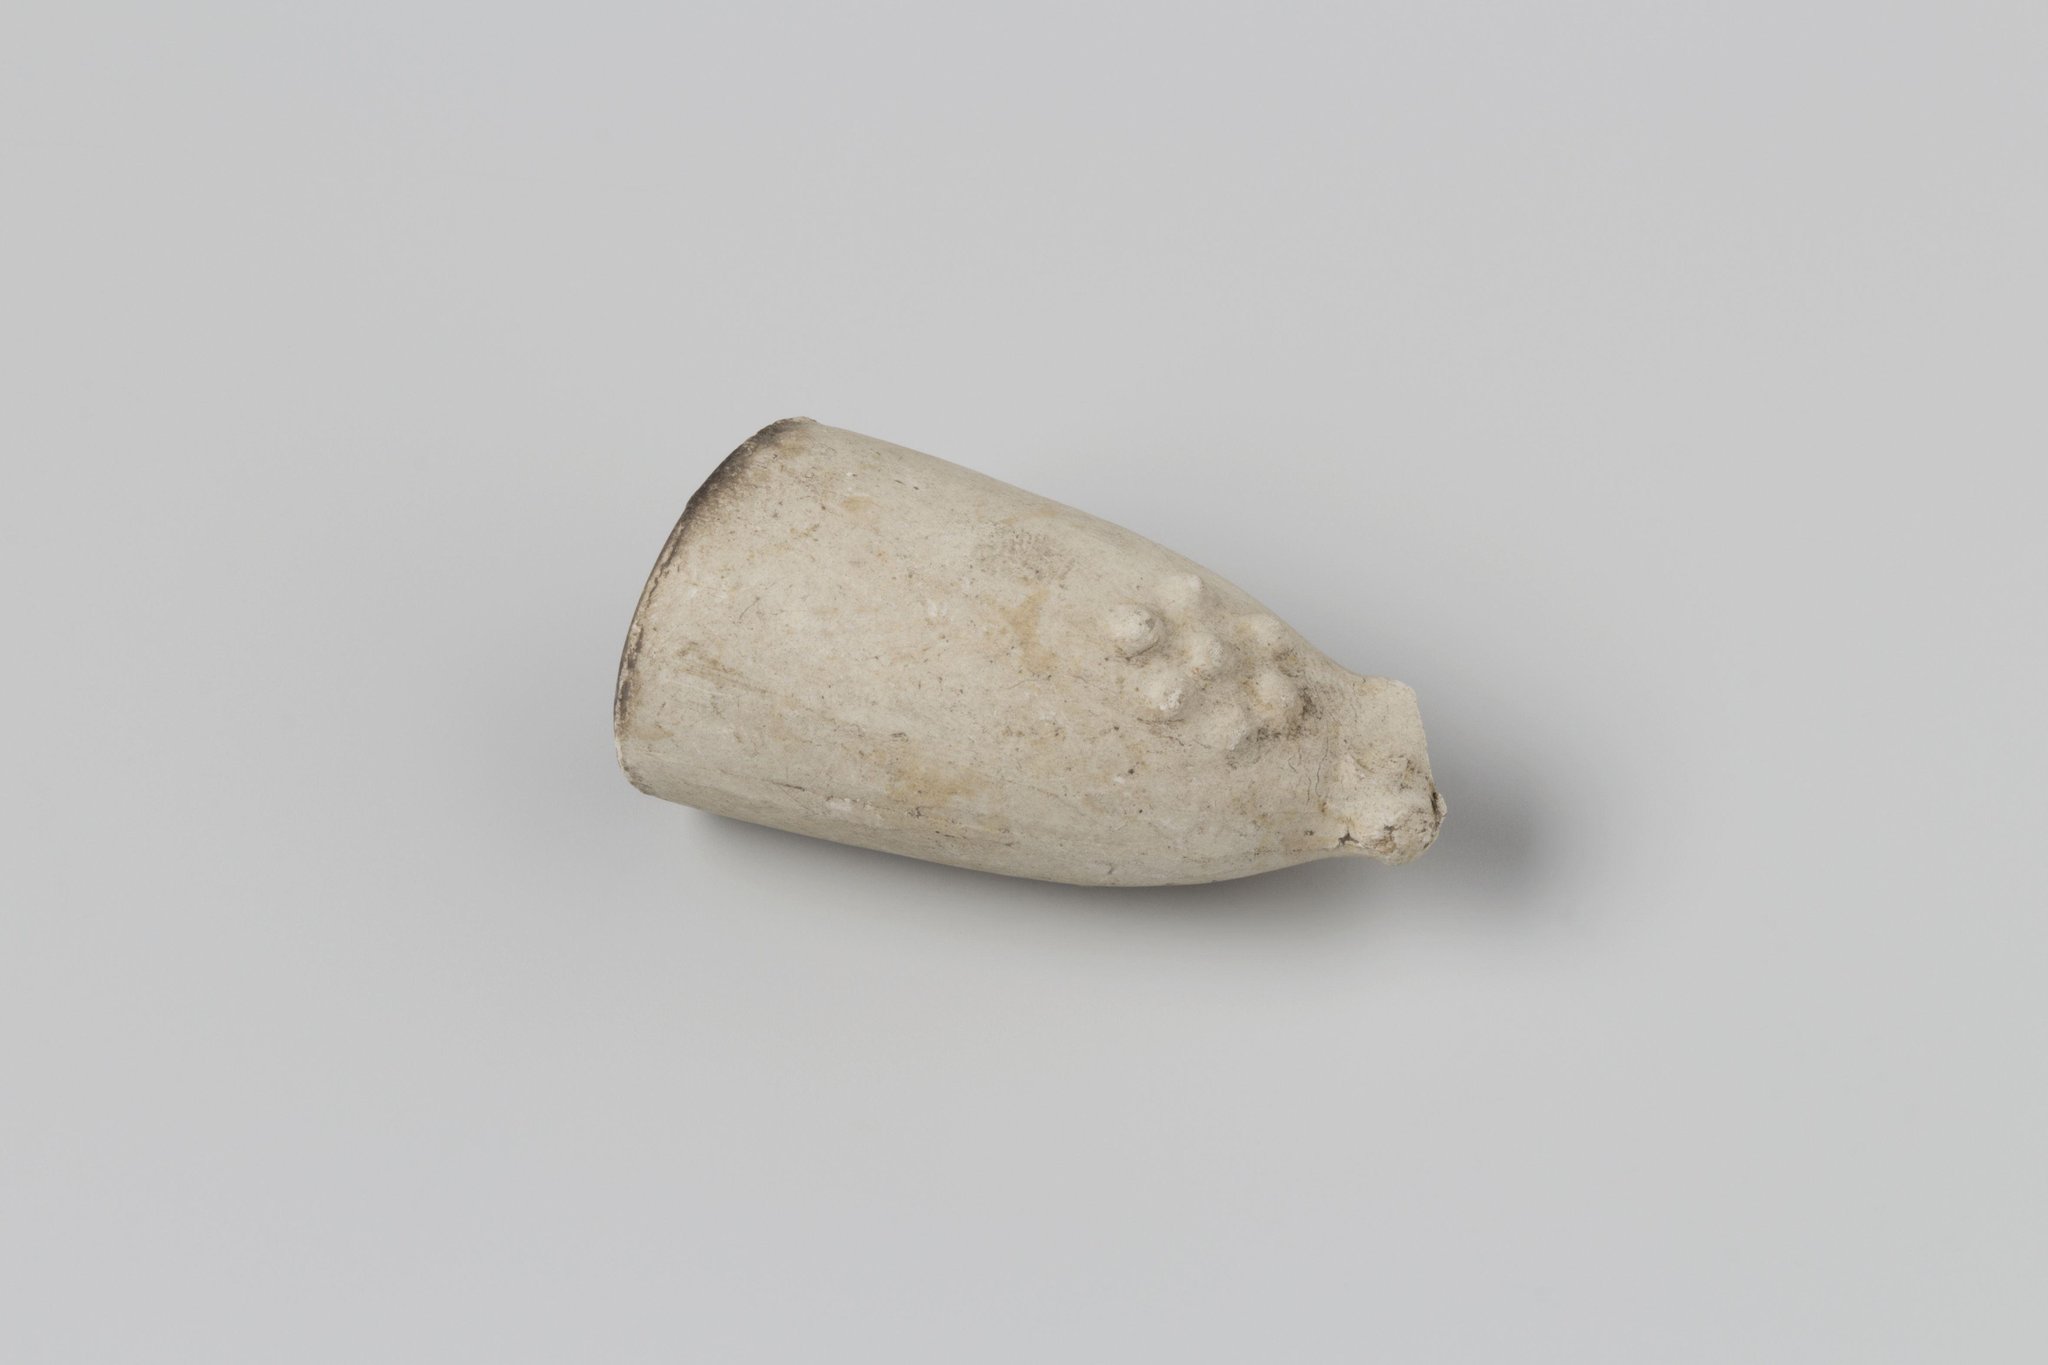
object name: pipe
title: Fragment pijpenkop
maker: Anonymous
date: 1700-1740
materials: clay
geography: netherlands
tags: directeur, hoogleraar, caspar jacob christiaan reuvens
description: Fragment pijpenkop met twee gestipte bloemen. Van de opgravingen op de Hofstede Arentsburg 1827-1831 onder toezicht van Professor Reuvens.